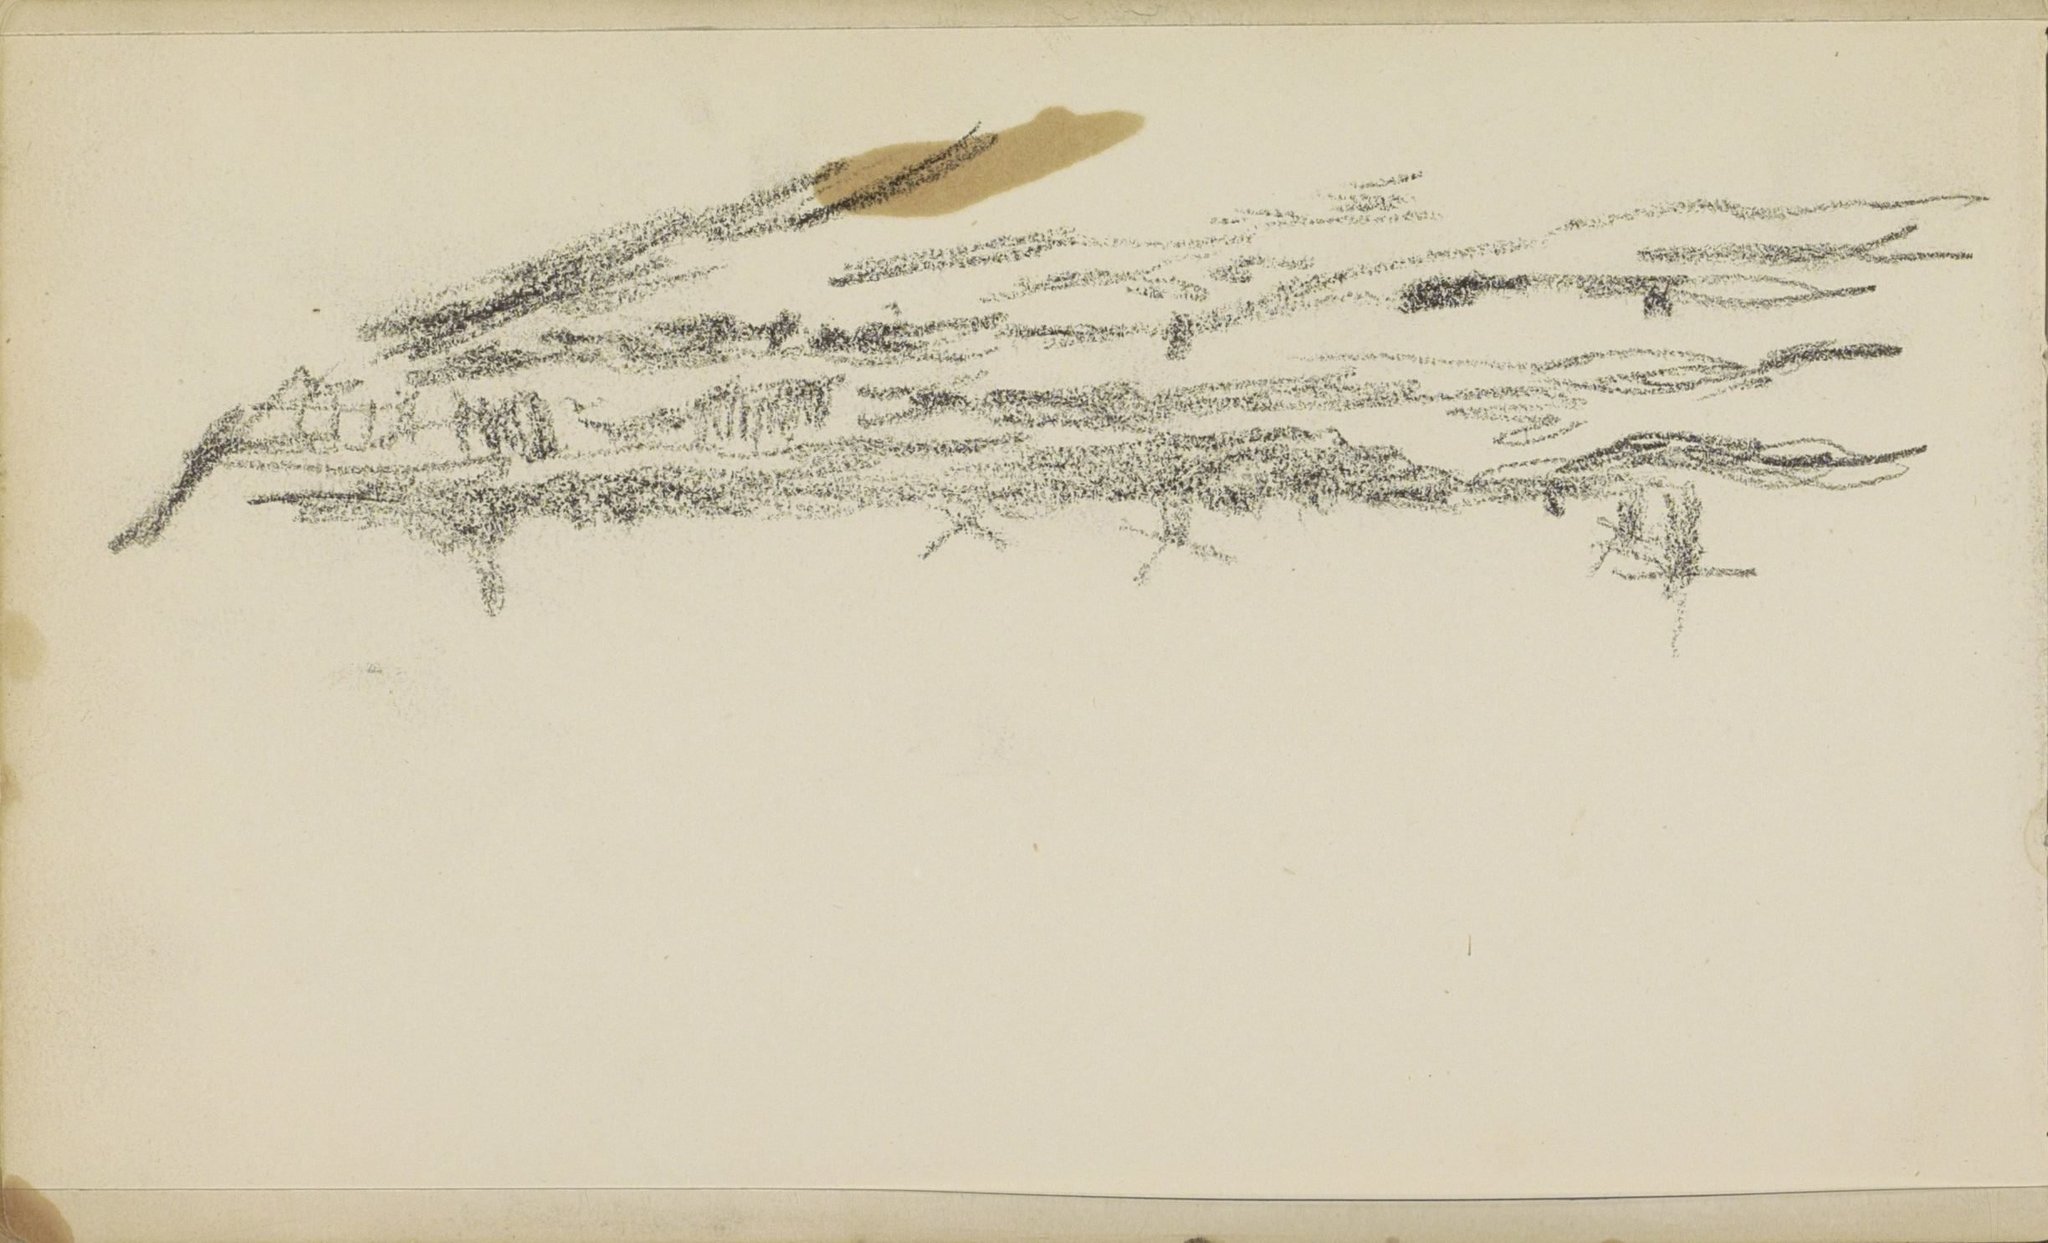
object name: sketchbook leaf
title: Landschap met molens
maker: jozef israëls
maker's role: draughtsman, painter, print maker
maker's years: 1824-1911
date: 1834-1911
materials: chalk, paper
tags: windmill in landscape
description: Blad 41 verso uit een schetsboek met 42 bladen.